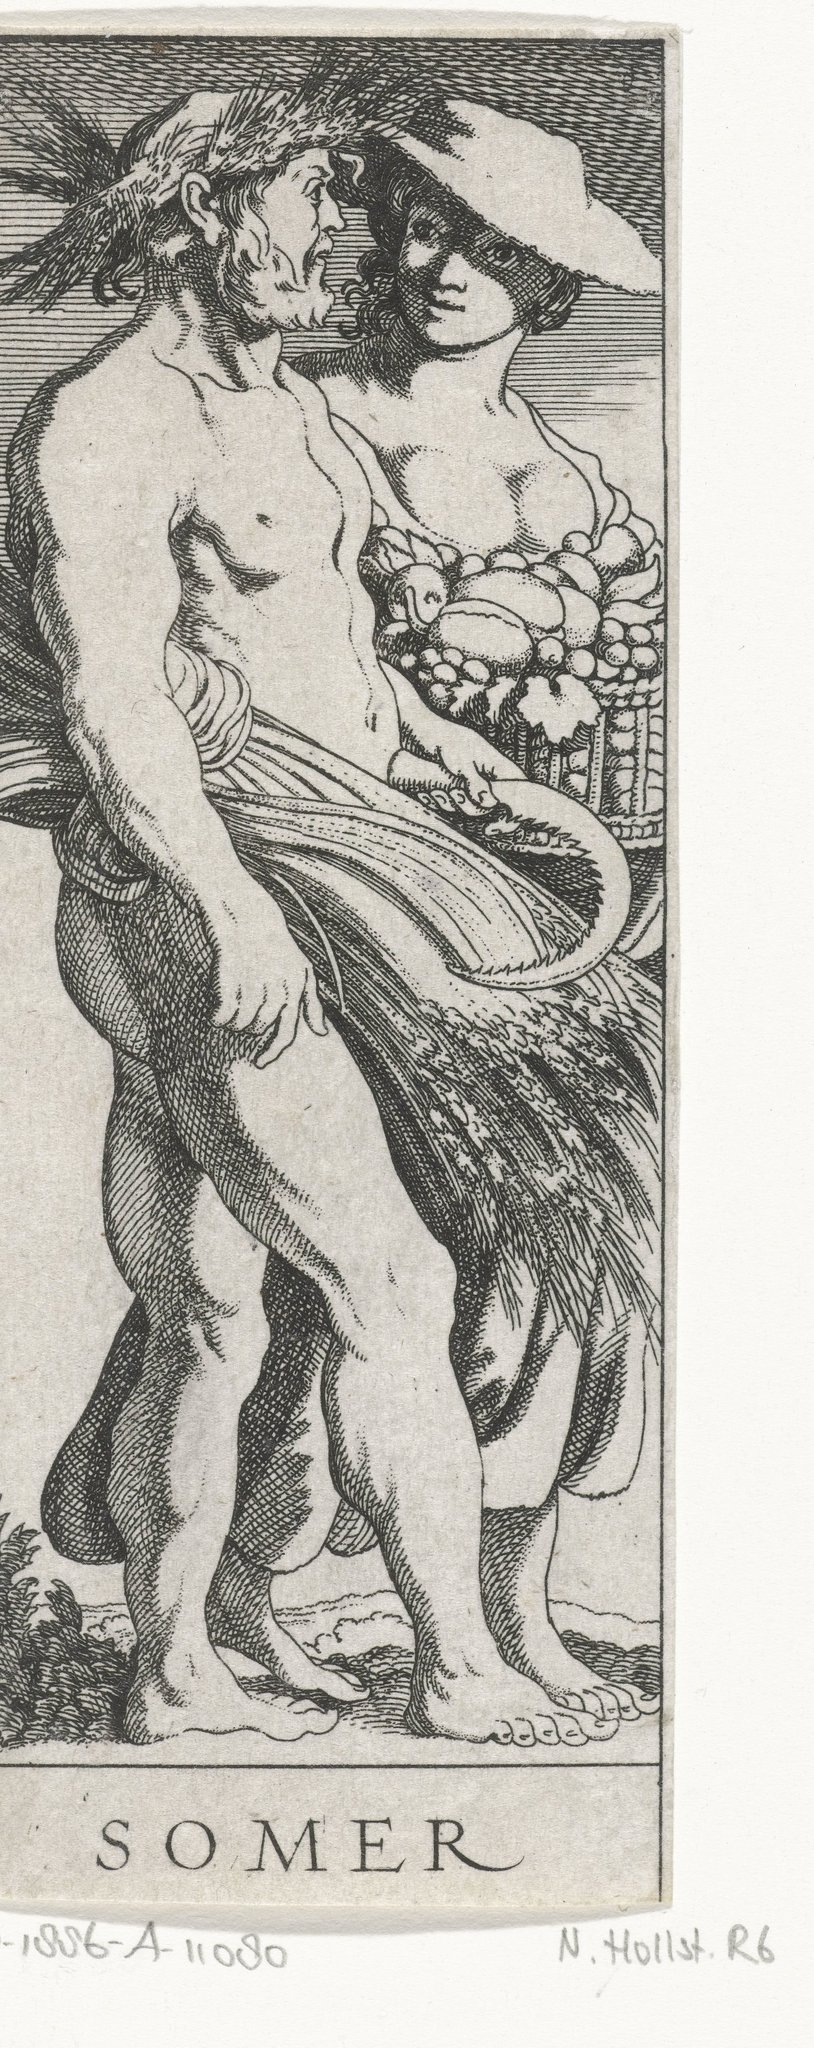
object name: print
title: Somer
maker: Anonymous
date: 1580-1678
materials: paper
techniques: etching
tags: summer, 'aestas'; 'estate' (ripa)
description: Een naakte man, wiens hoofd met korenaren is omkransd, draagt een sikkel en een schoof koren. Naast hem loopt een vrouw met een korf vruchten in haar armen. Haar hoofd is getooid met een hoed.